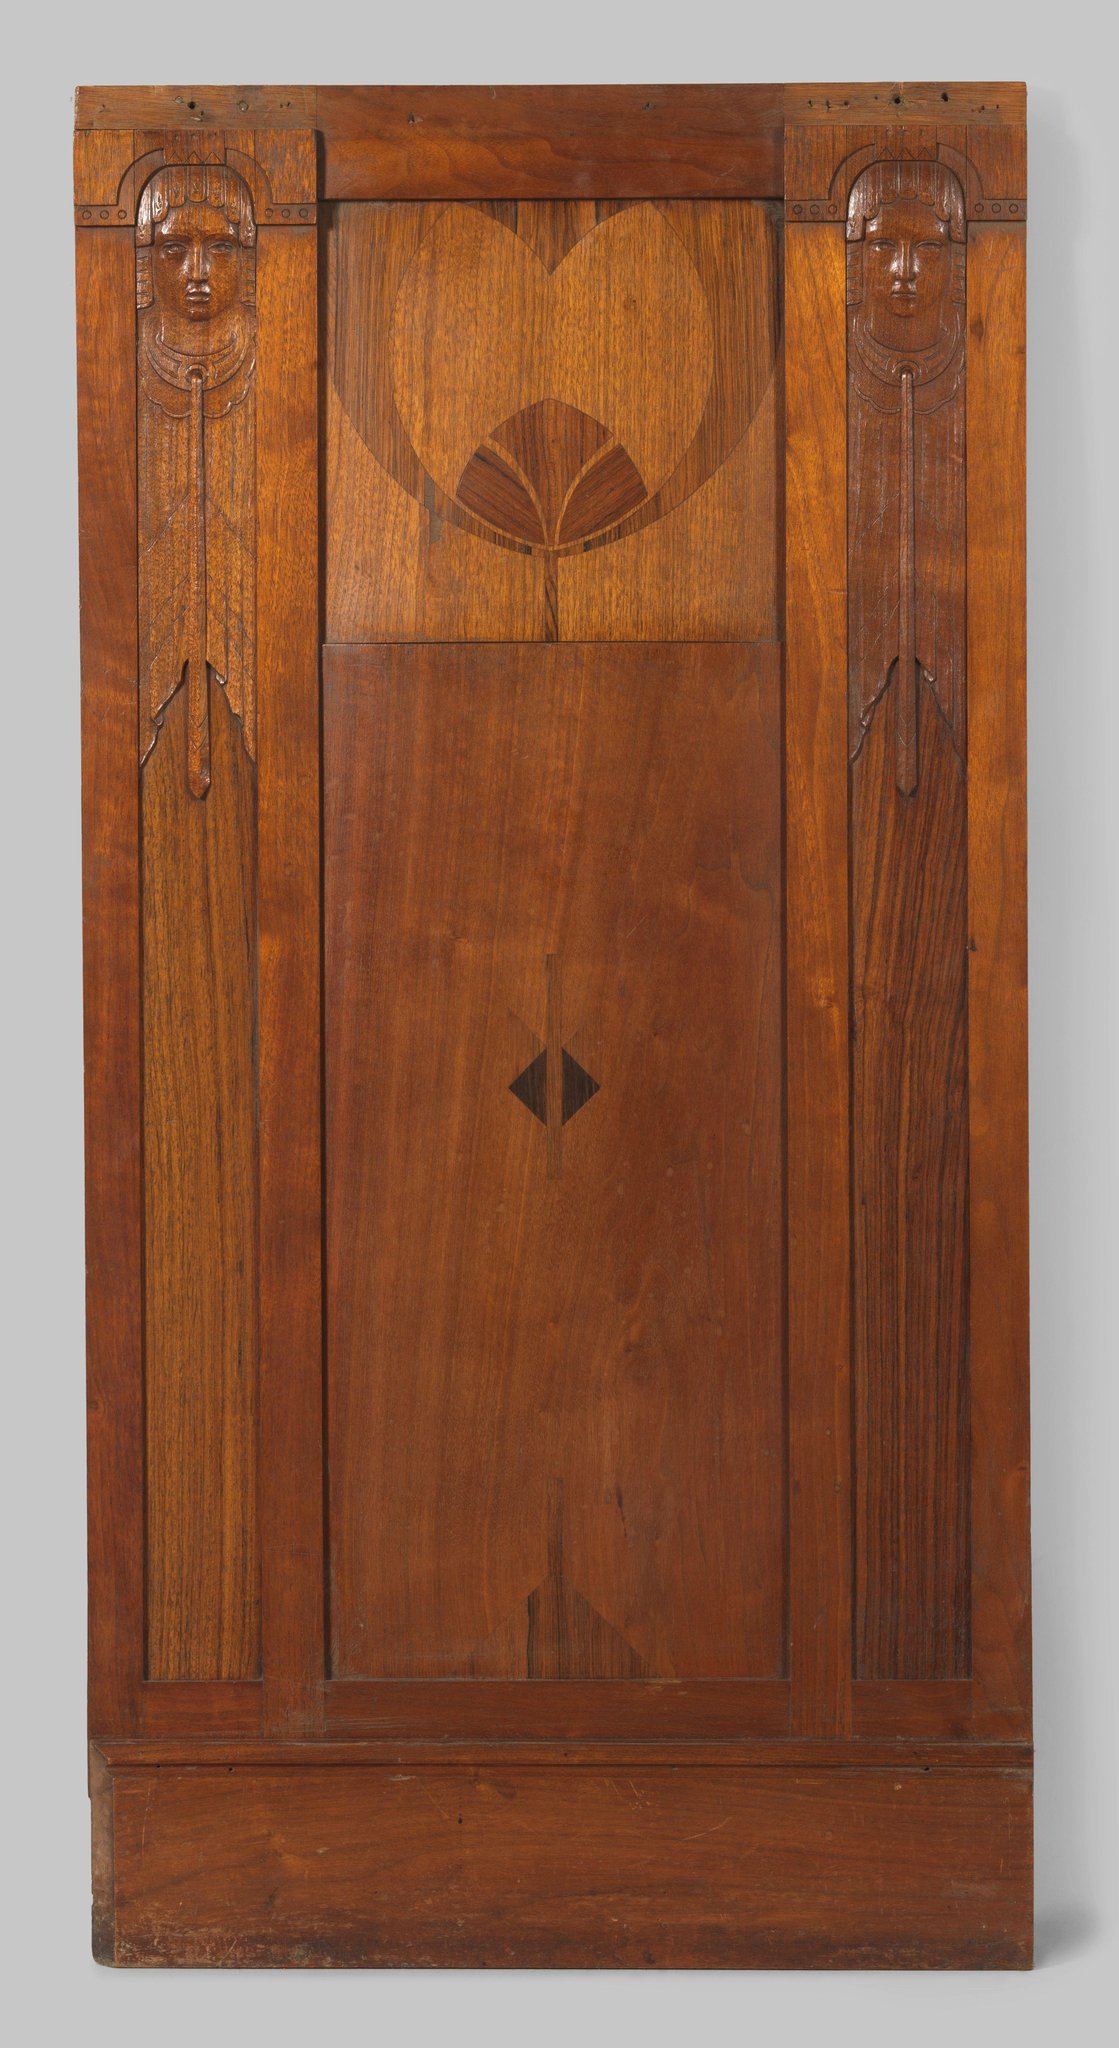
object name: betimmering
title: Lambrizering, onderdeel van een betimmering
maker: napoleon le grand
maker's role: furniture worker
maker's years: 1857-1932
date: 1900-1905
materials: wood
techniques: marquetry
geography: amsterdam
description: Lambrizering, onderdeel van een betimmering, van noten en palissander en diverse andere houtsoorten.